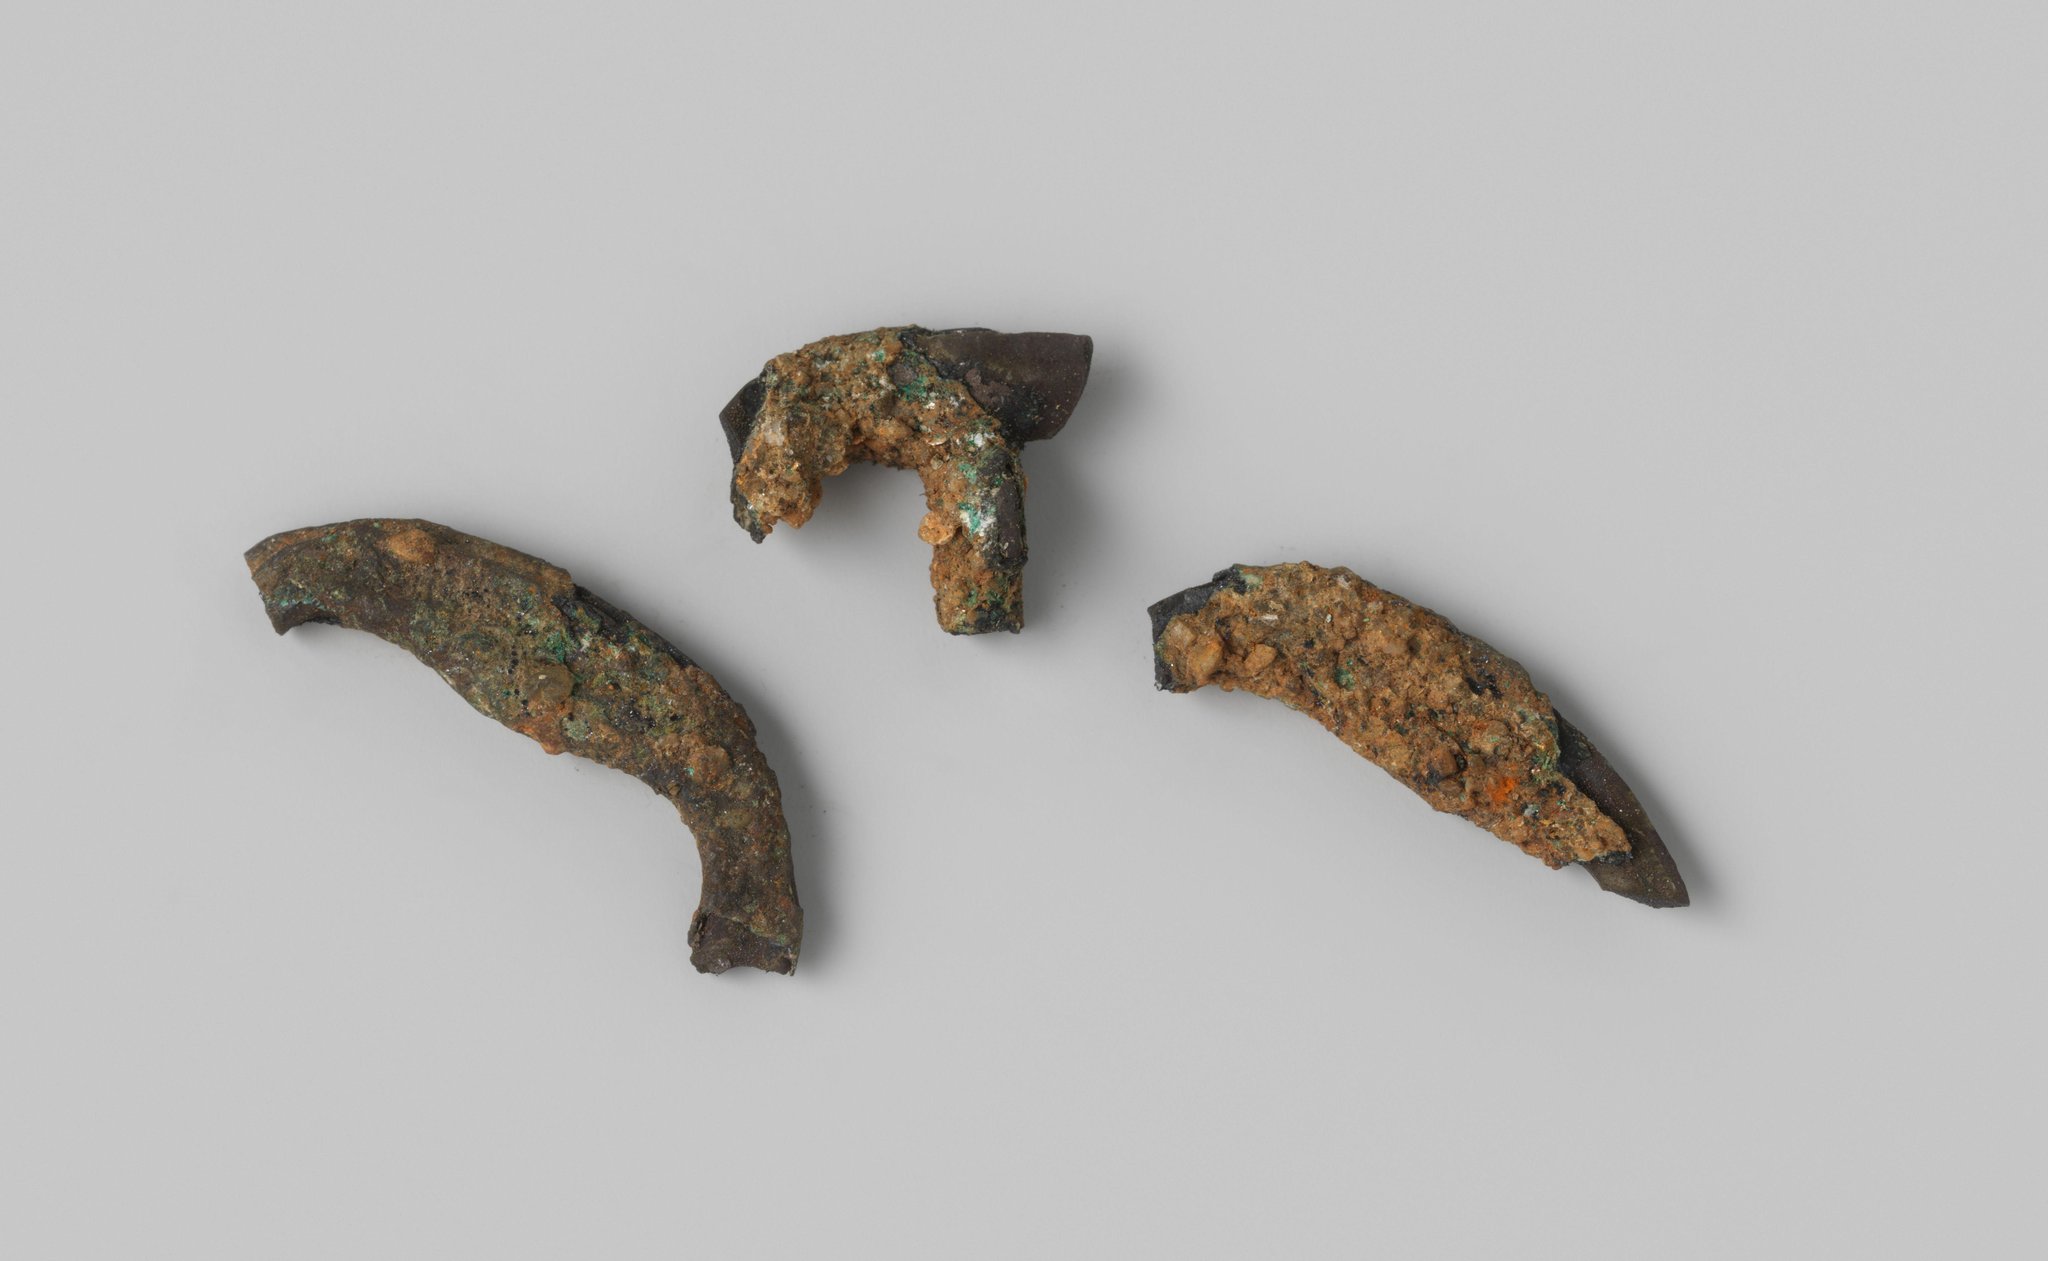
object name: shoe buckle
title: Fragmenten schoengesp uit het wrak van de Oost-Indiëvaarder Hollandia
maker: Anonymous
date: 1700-1743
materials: silver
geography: netherlands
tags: verenigde oostindische compagnie, hollandia (schip), annet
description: Buckle, chape buckle, shoe buckle; fragment of ring, heavily corroded, sim. NG 1980-27H2049.